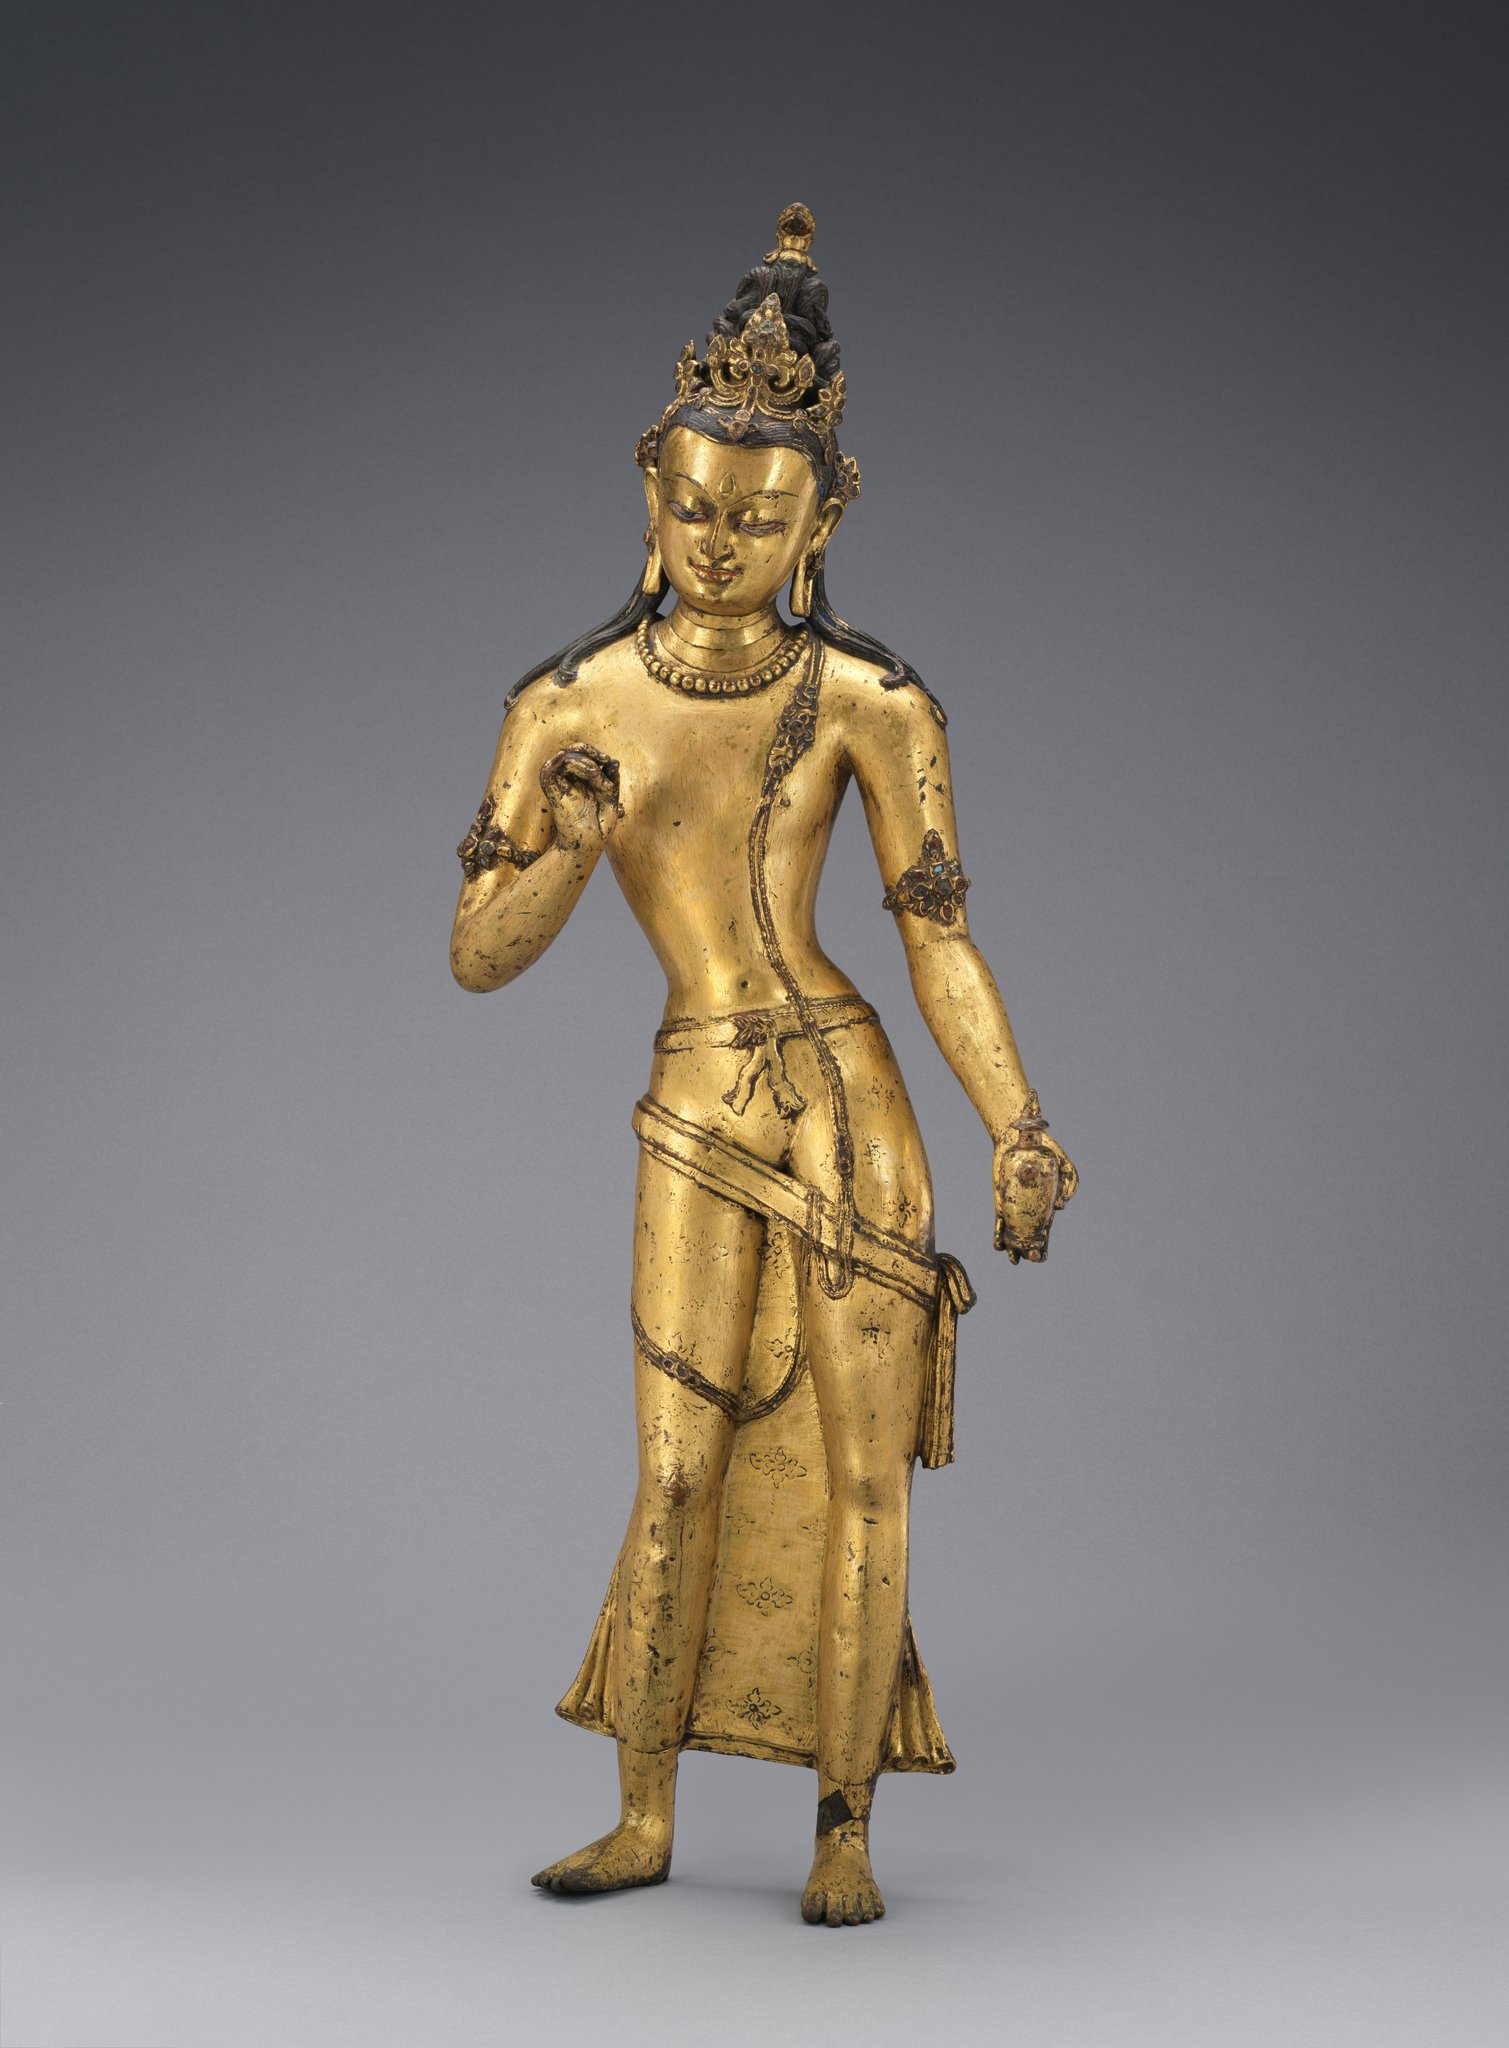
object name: figure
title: The Bodhisattva Maitreya, the Buddha of the Future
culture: nepali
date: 1001-1100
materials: copper alloy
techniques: gilding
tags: buddhism,buddha,maitreya